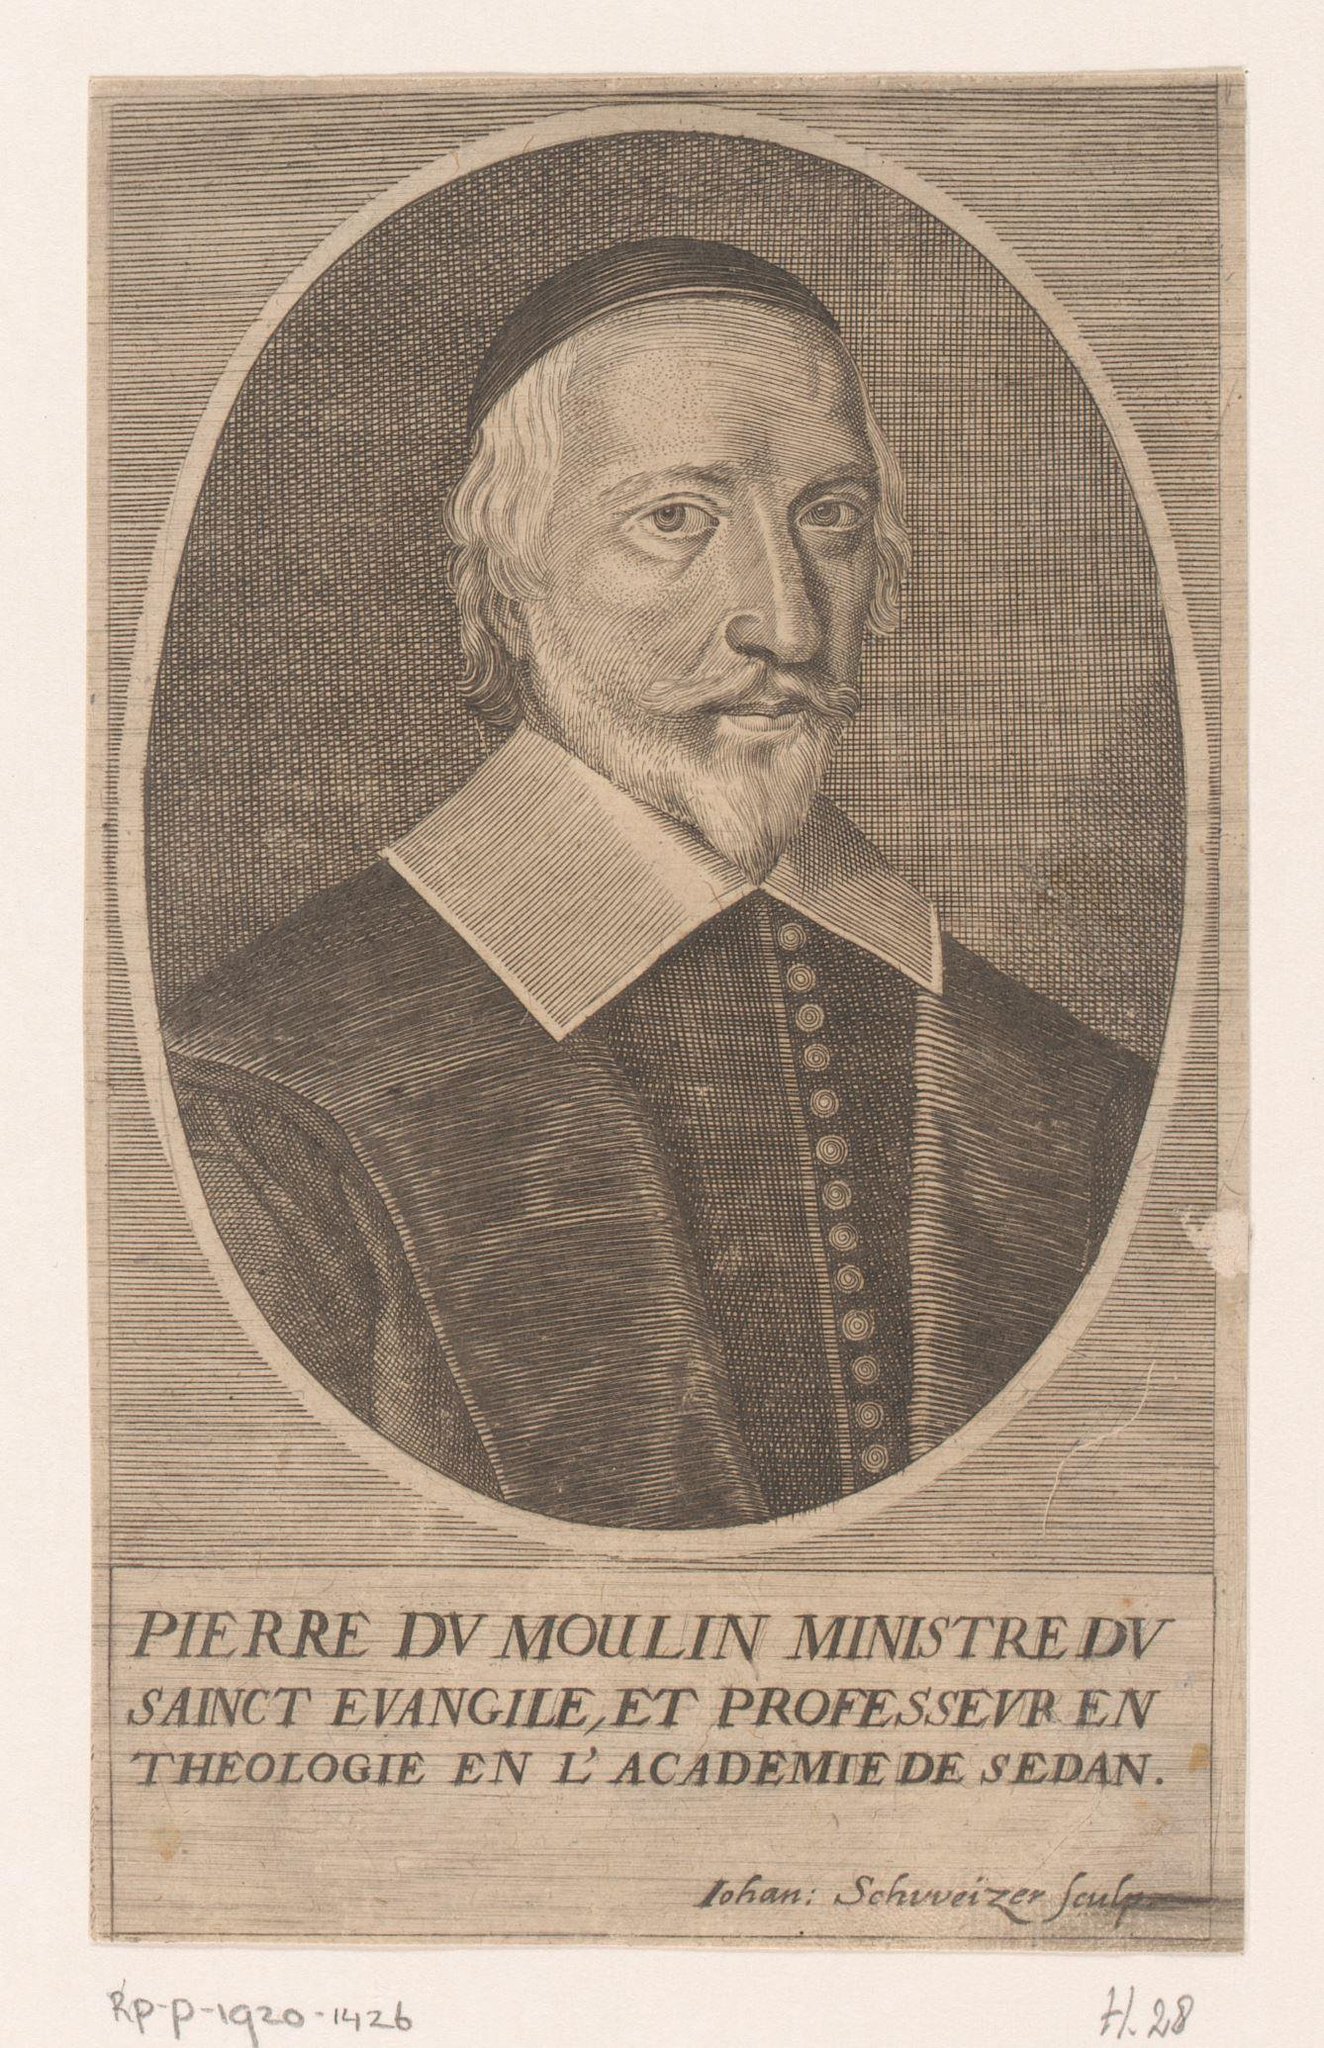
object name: print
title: Portret van Pierre du Moulin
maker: johann schweizer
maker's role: print maker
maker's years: 1625-1670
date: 1635-1670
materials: paper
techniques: engraving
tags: theologian, historical persons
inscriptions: collector's mark: Lugt 2228